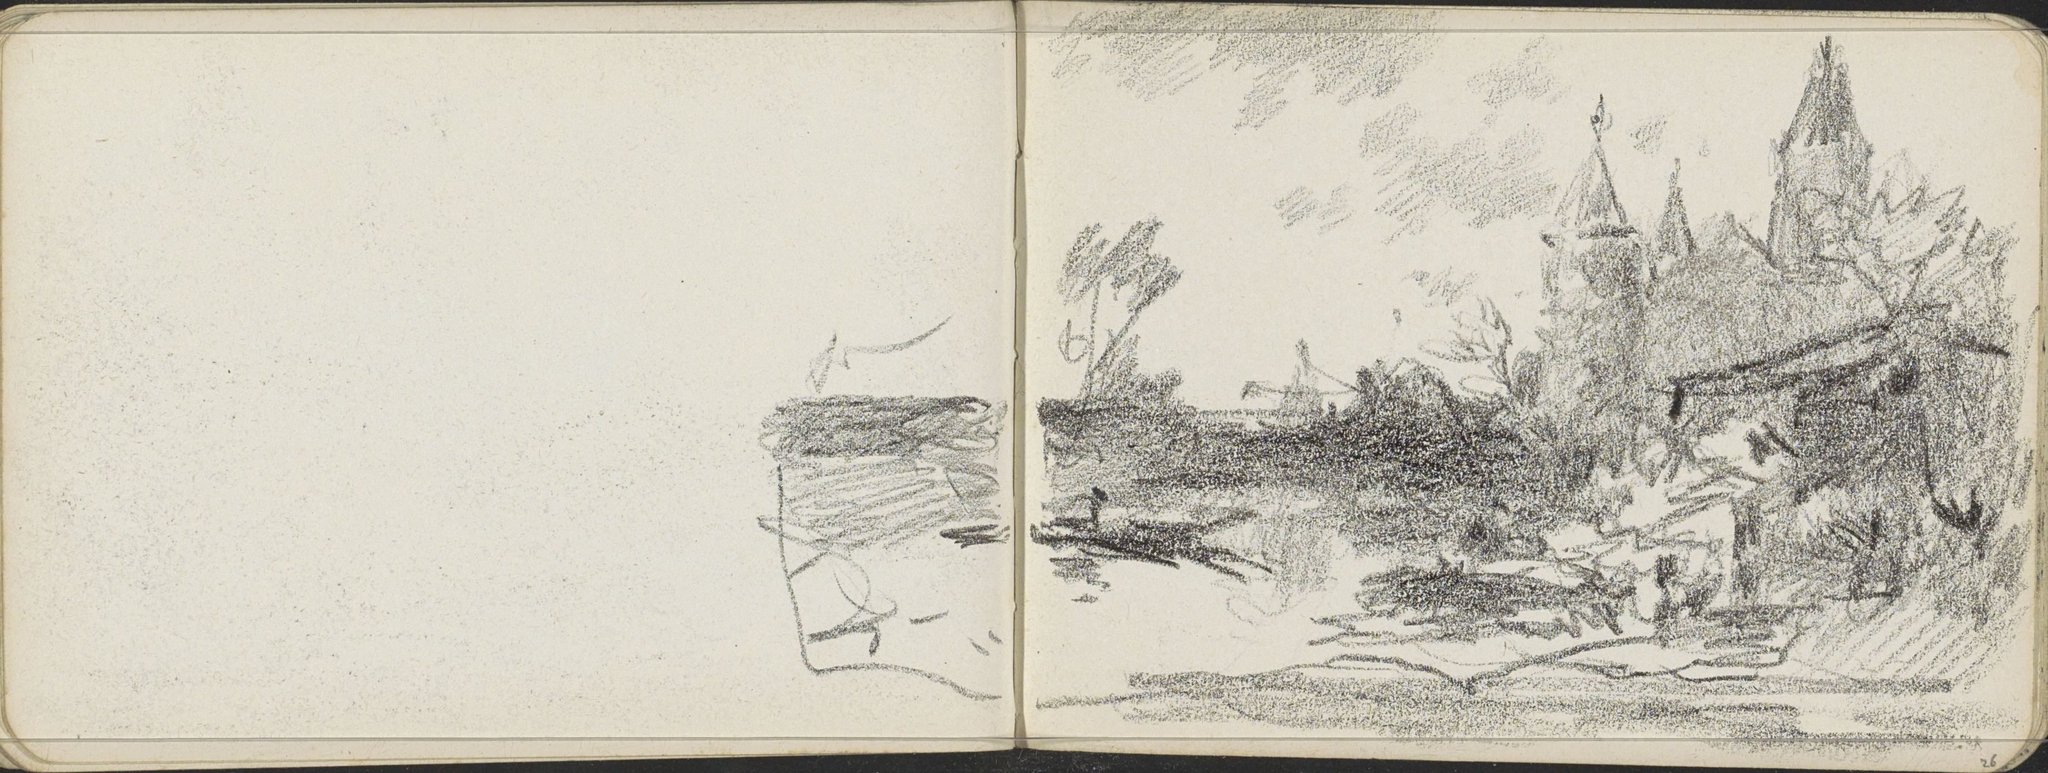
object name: sketchbook leaf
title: Amsterdamse Poort te Haarlem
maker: willem cornelis rip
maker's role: draughtsman, painter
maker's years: 1856-1922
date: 1907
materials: chalk, paper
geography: haarlem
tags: towers ~ fortified city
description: Blad 25 verso en 26 recto uit een schetsboek met 41 bladen.